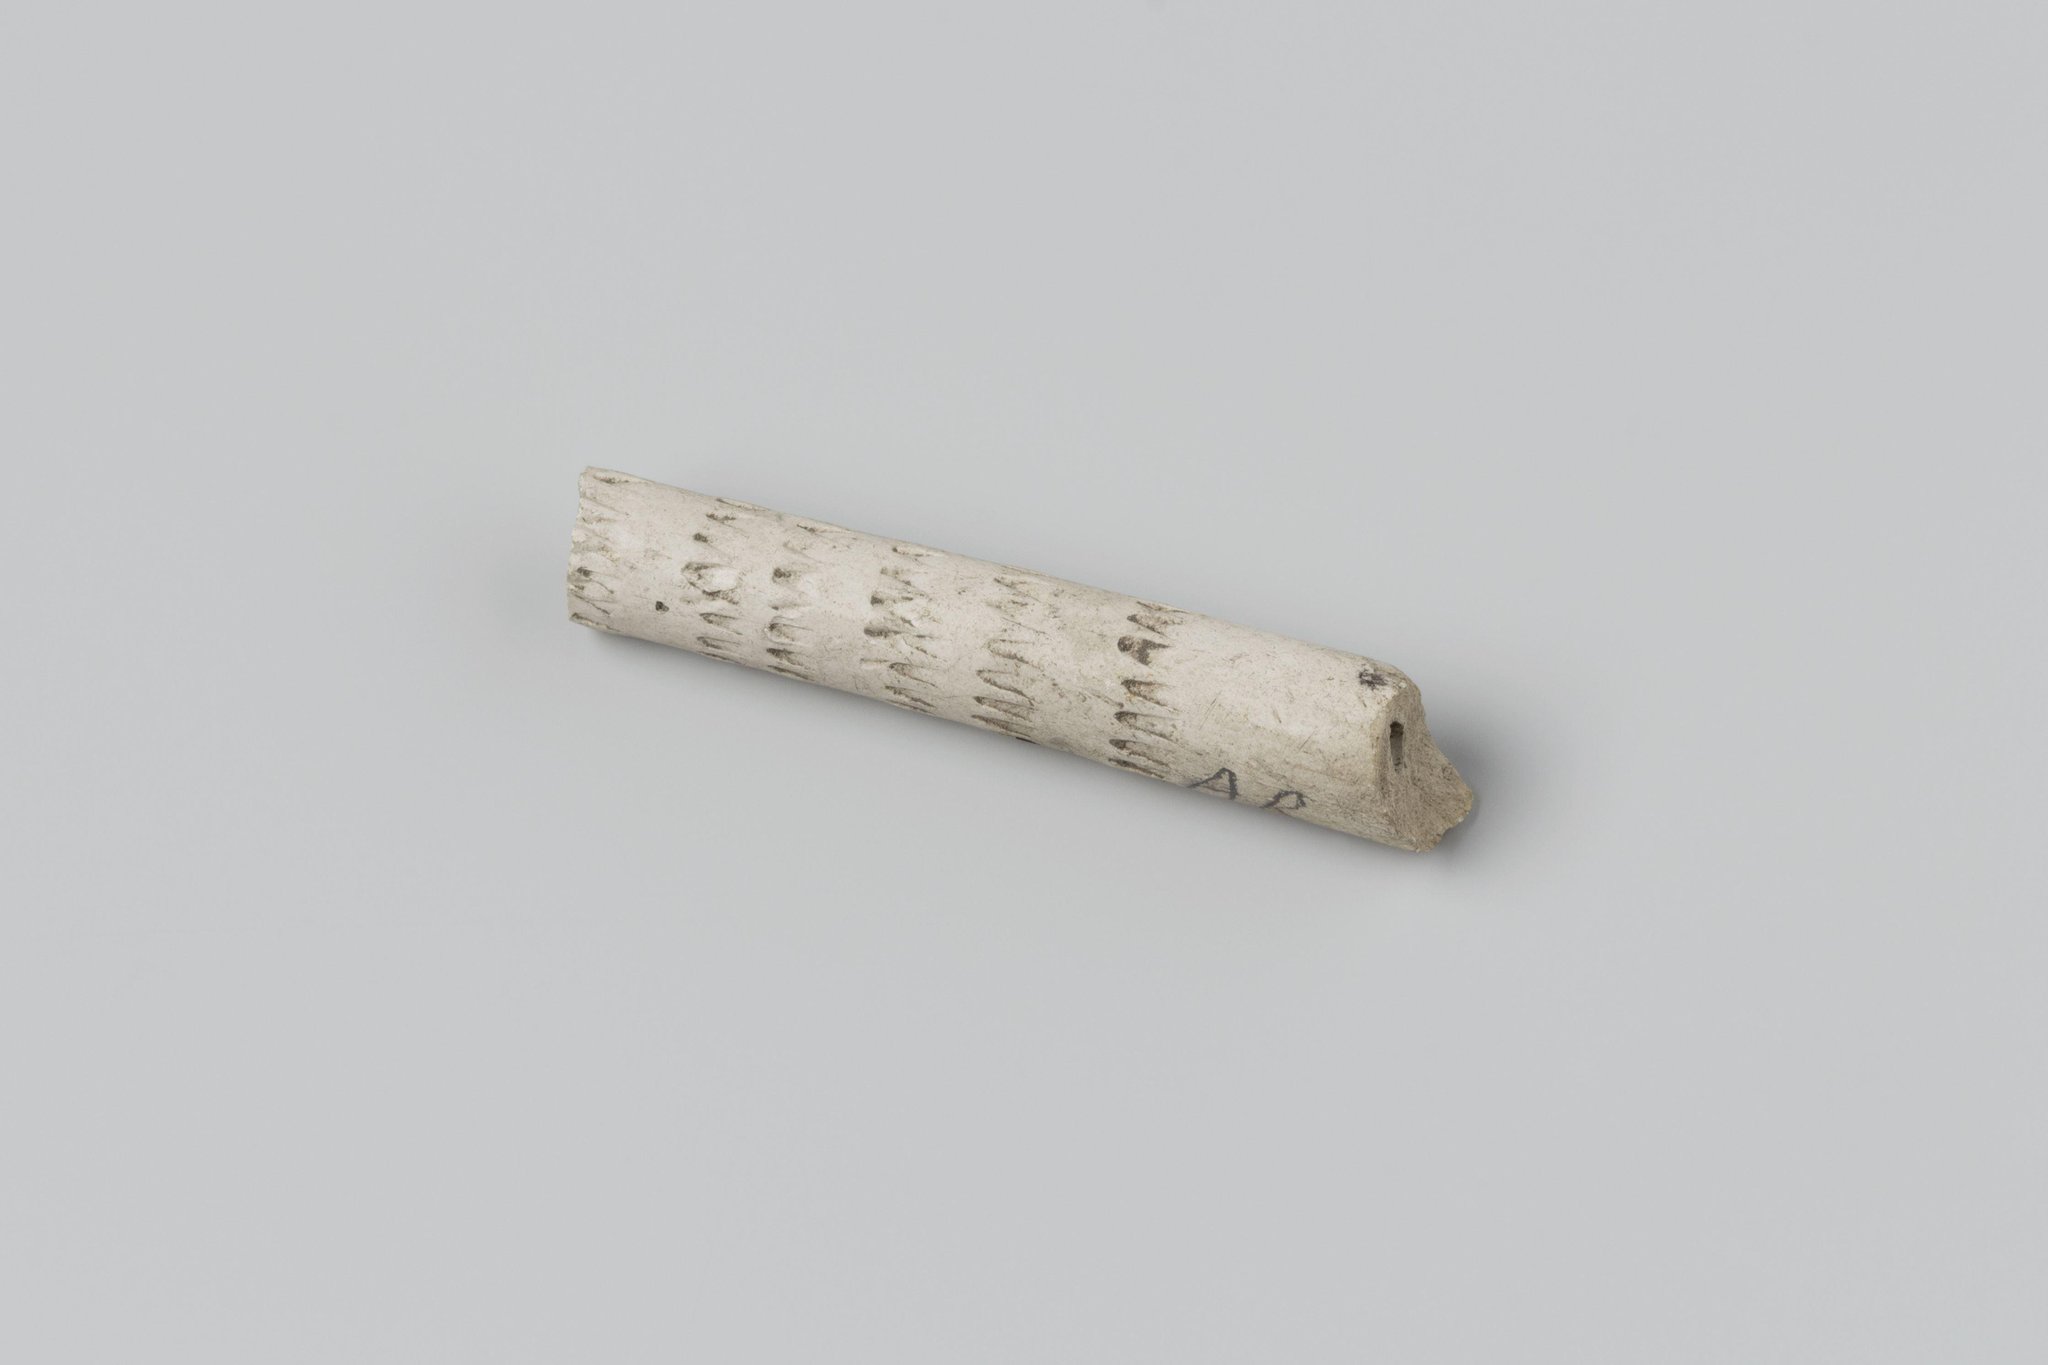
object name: fragment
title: Fragment pijpensteel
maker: Anonymous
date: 1600-1800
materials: clay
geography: netherlands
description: Fragment pijpensteel met 6 zigzaglijnen rondom. Van de opgravingen op de Hofstede Arentsburg 1827-1831 onder toezicht van Professor Reuvens.